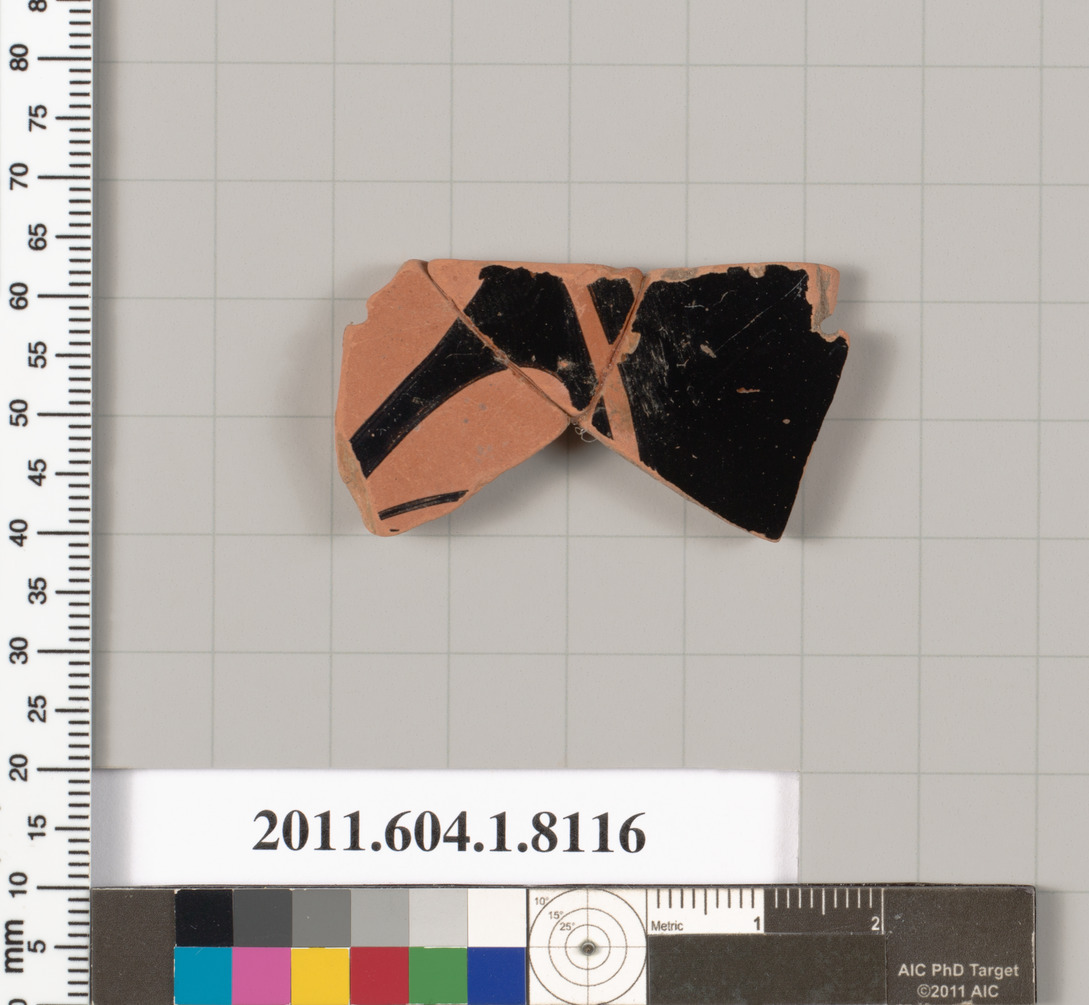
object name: kylix fragment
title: Terracotta fragment of a kylix (drinking cup)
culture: greek, attic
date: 534-468 BCE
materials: terracotta